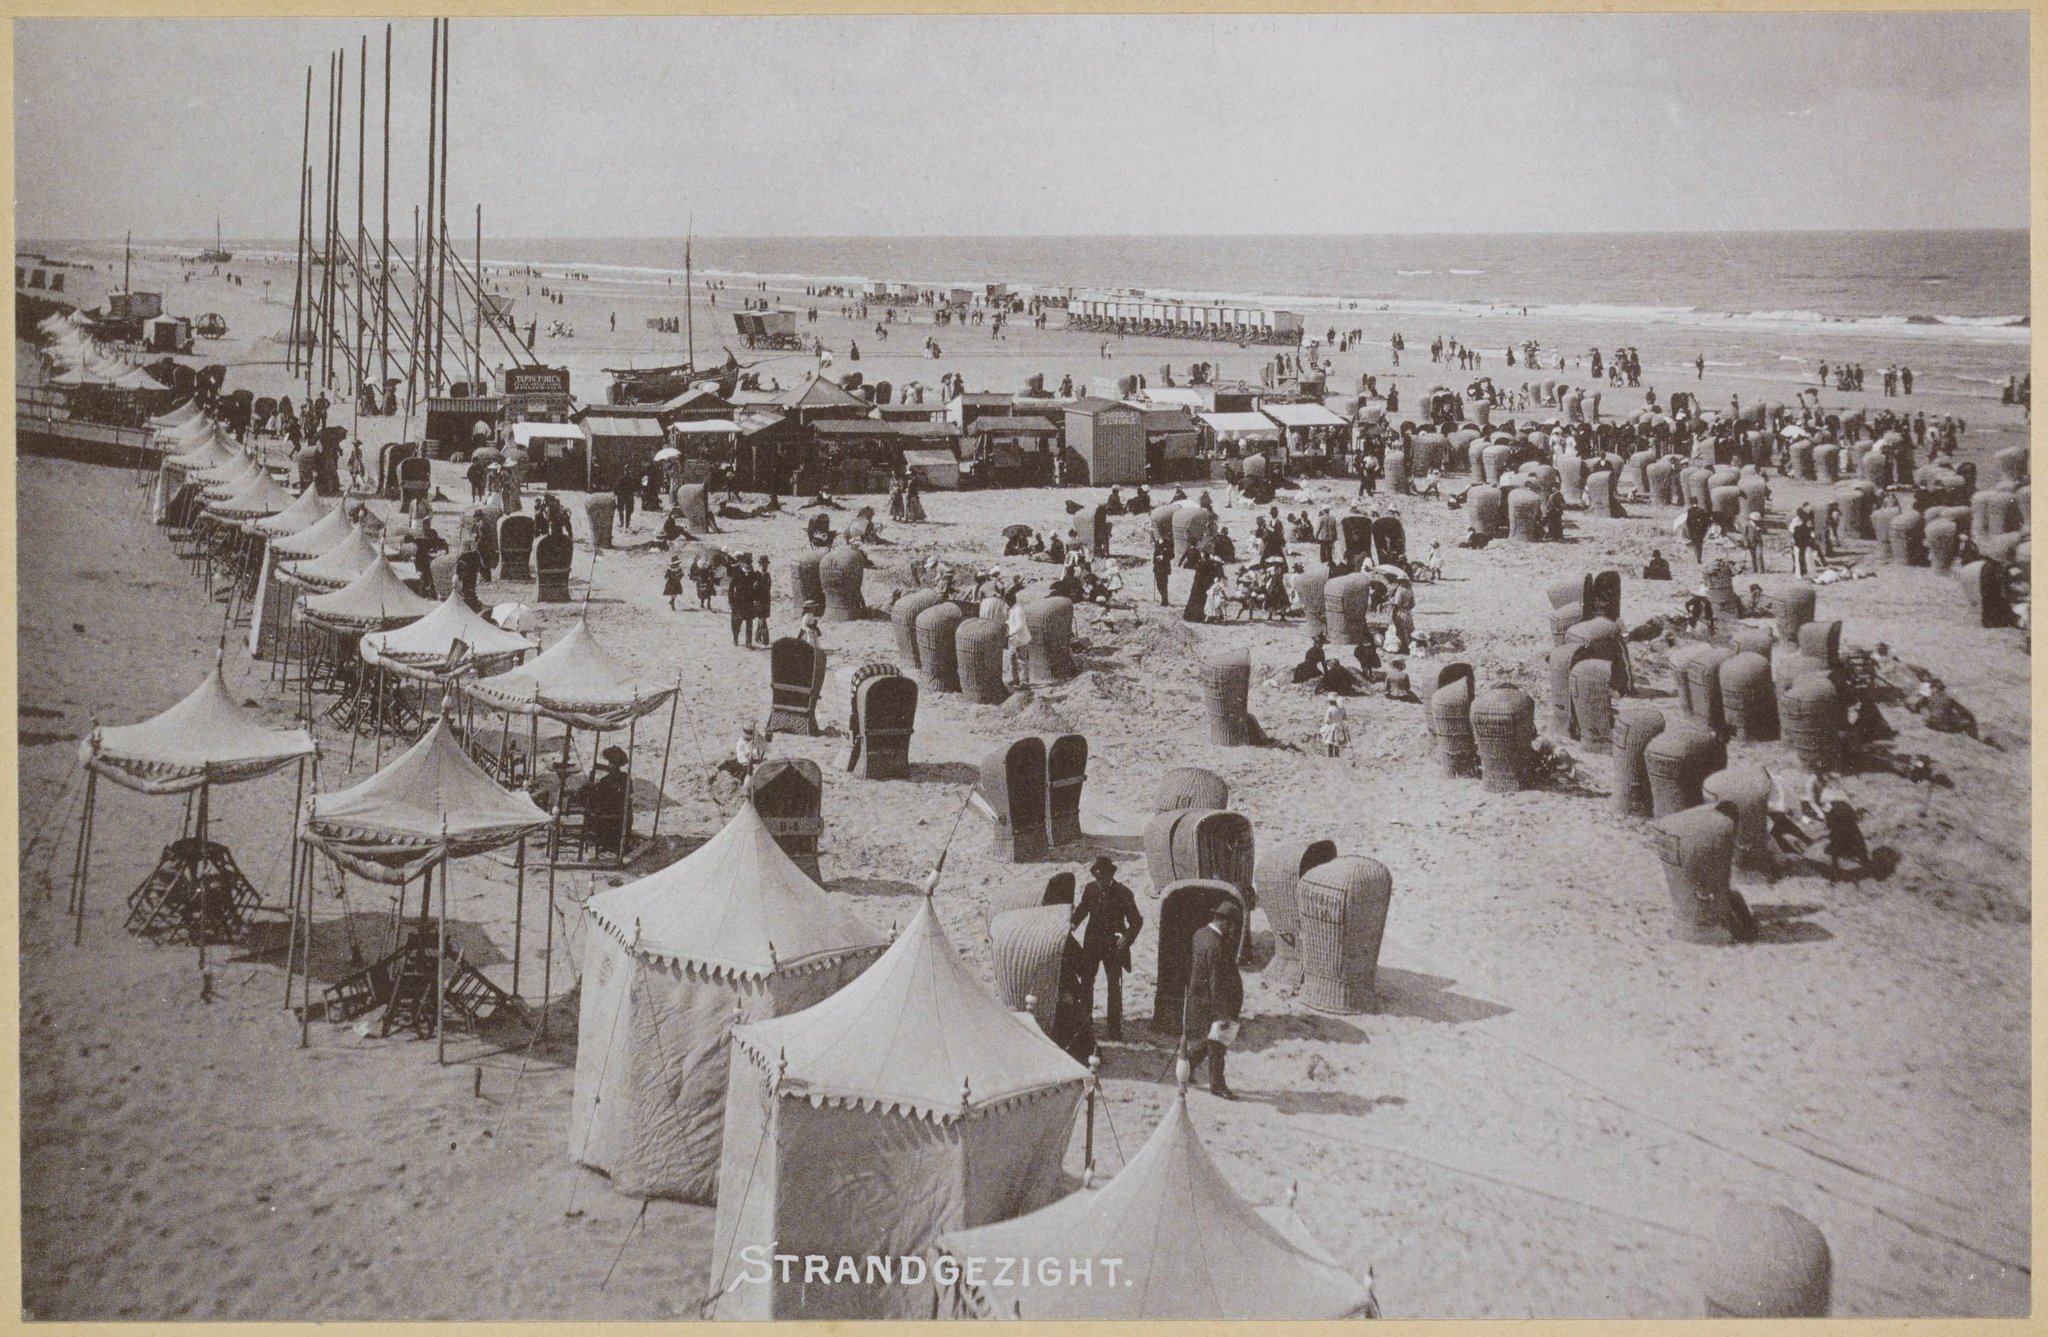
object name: photograph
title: Strandgezicht.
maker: Anonymous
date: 1890-1910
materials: cardboard, paper, ink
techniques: photograph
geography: scheveningen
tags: beach (as place of recreation)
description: Onderdeel van Leporelloalbum met opnames van Scheveningen.